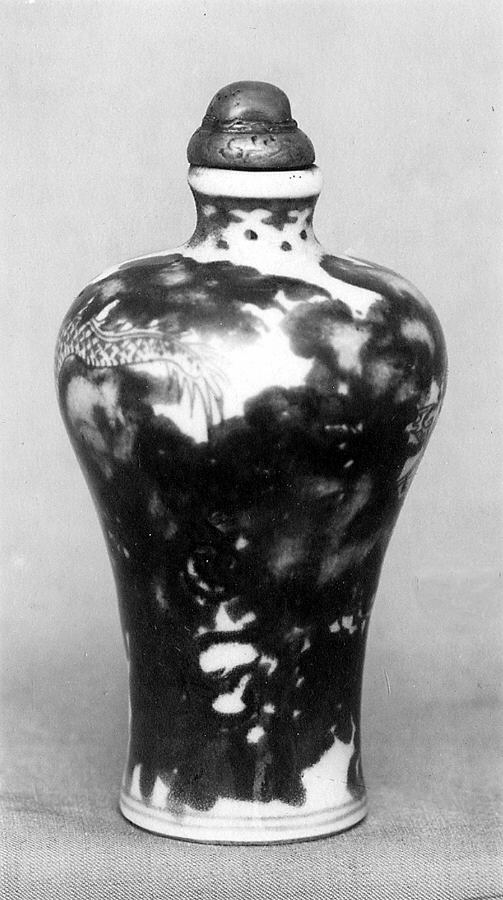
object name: snuff bottle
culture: chinese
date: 1736-1795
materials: porcelain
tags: dragons